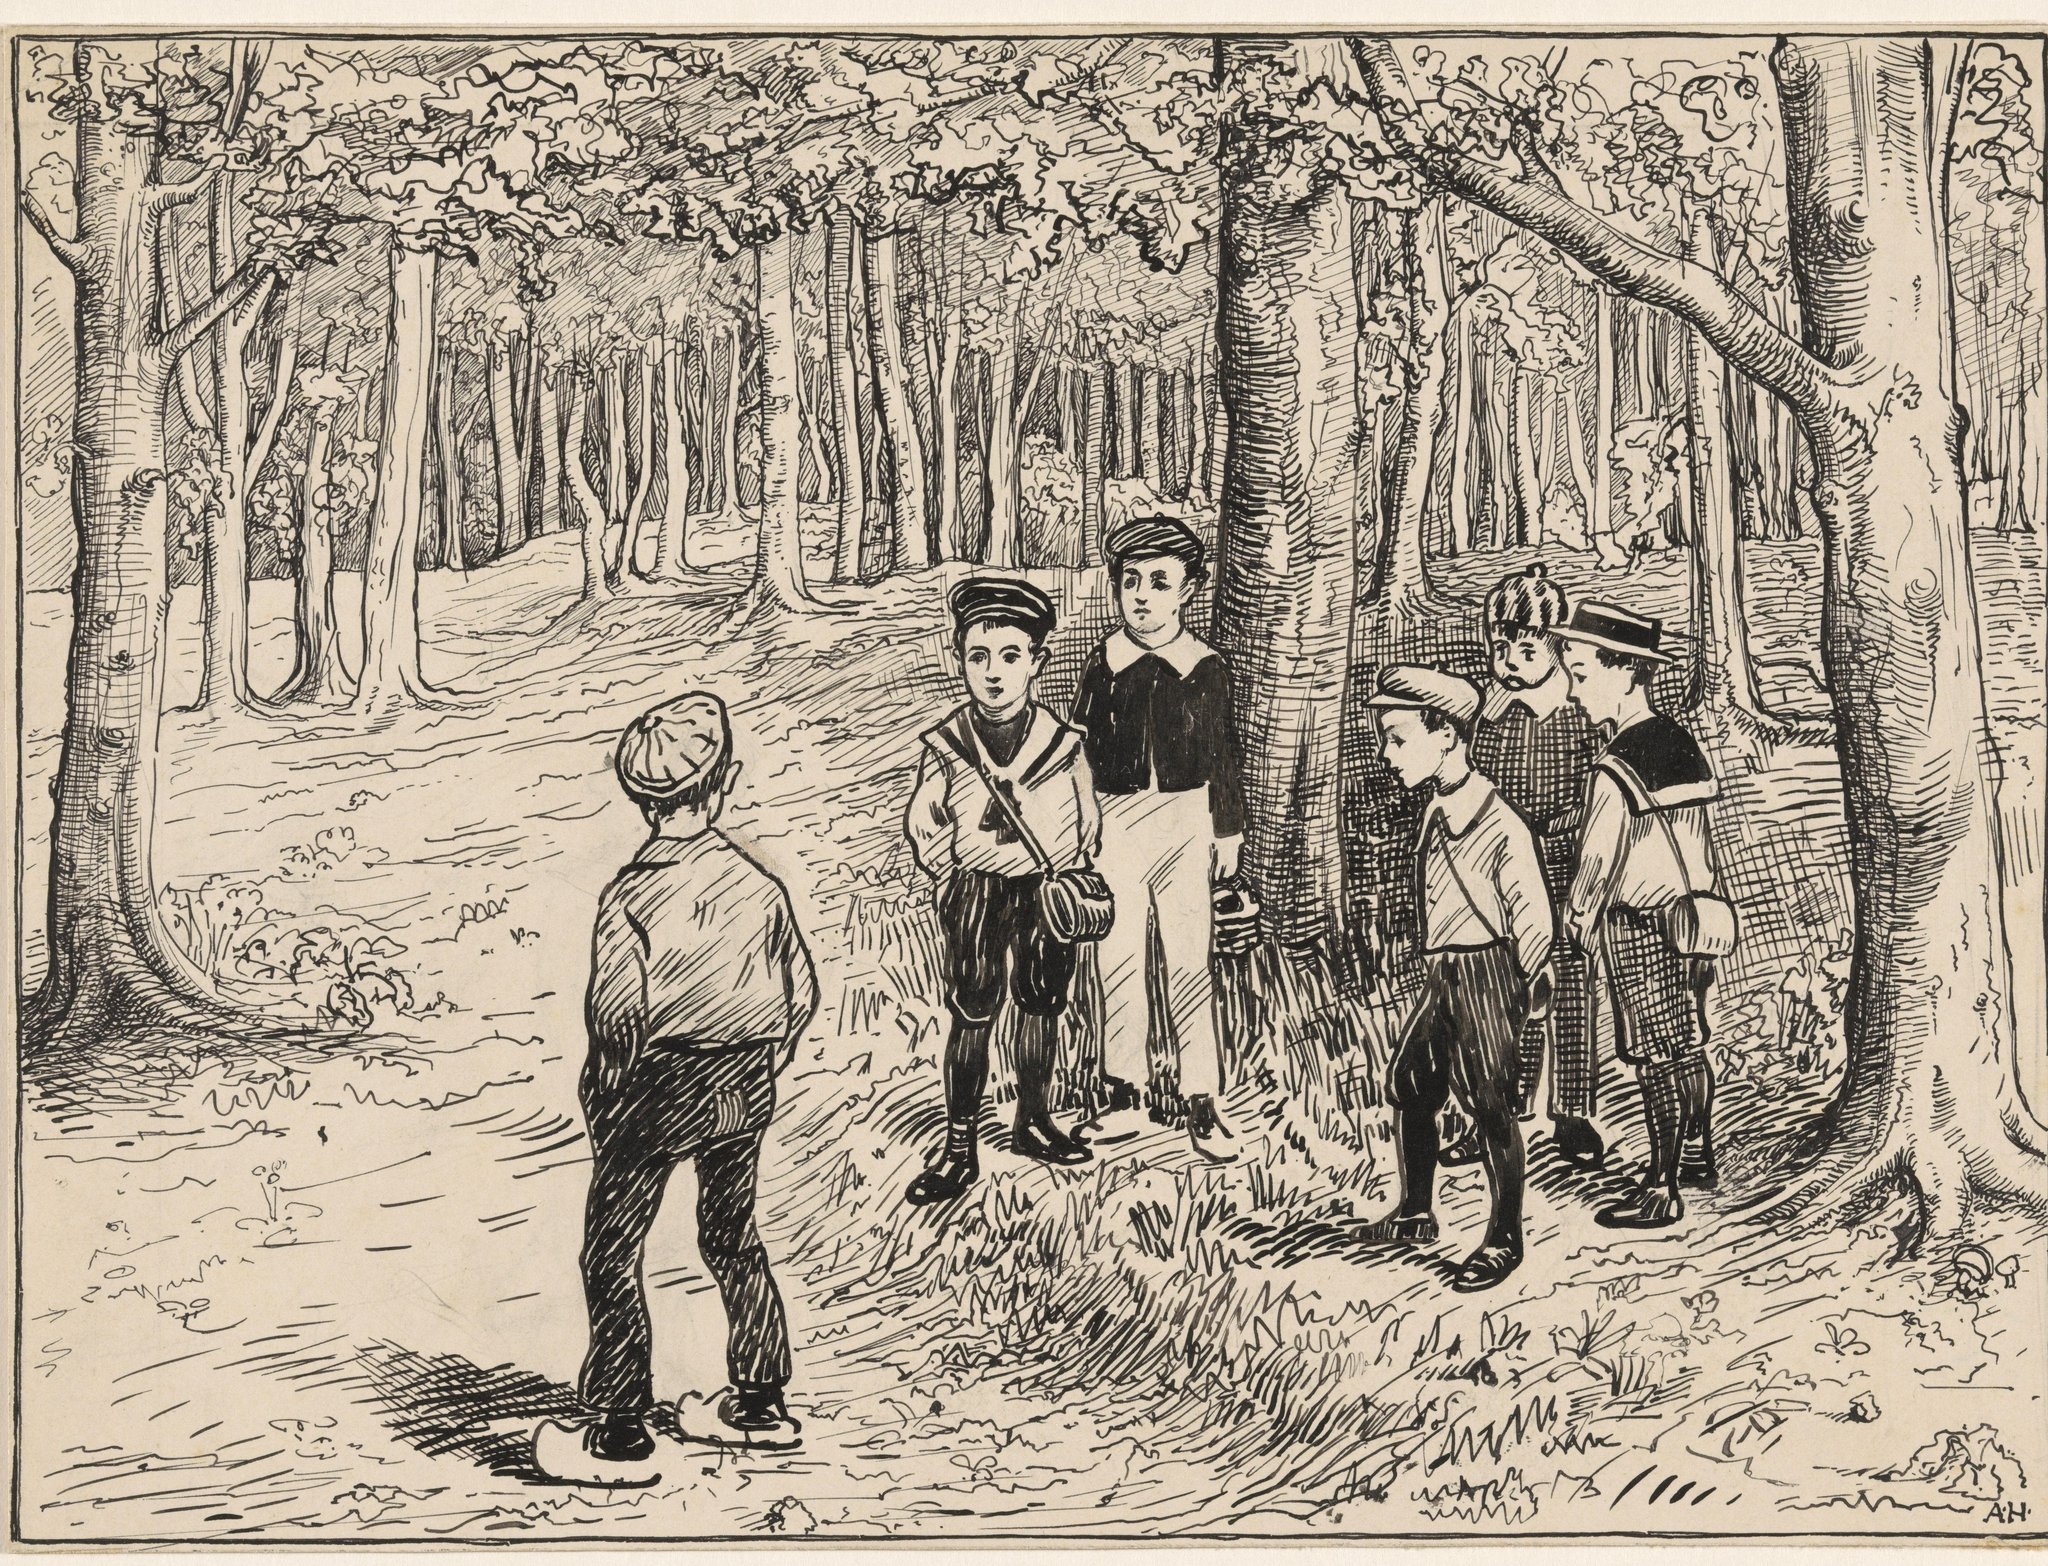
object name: drawing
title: Groep jongens in een bos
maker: albert hemelman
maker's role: draughtsman, print maker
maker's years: 1883-1951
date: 1893-1951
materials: cardboard, ink, pencil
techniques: pen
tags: boy (child between toddler and youth), forest, wood (+ landscape with figures, staffage)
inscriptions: collector's mark: Lugt 2228, signature: ‘A.H.’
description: Een groep van vijf jongens staat onder een boom in een bos. Een zesde jongen staat iets van de groep af op een bospad.